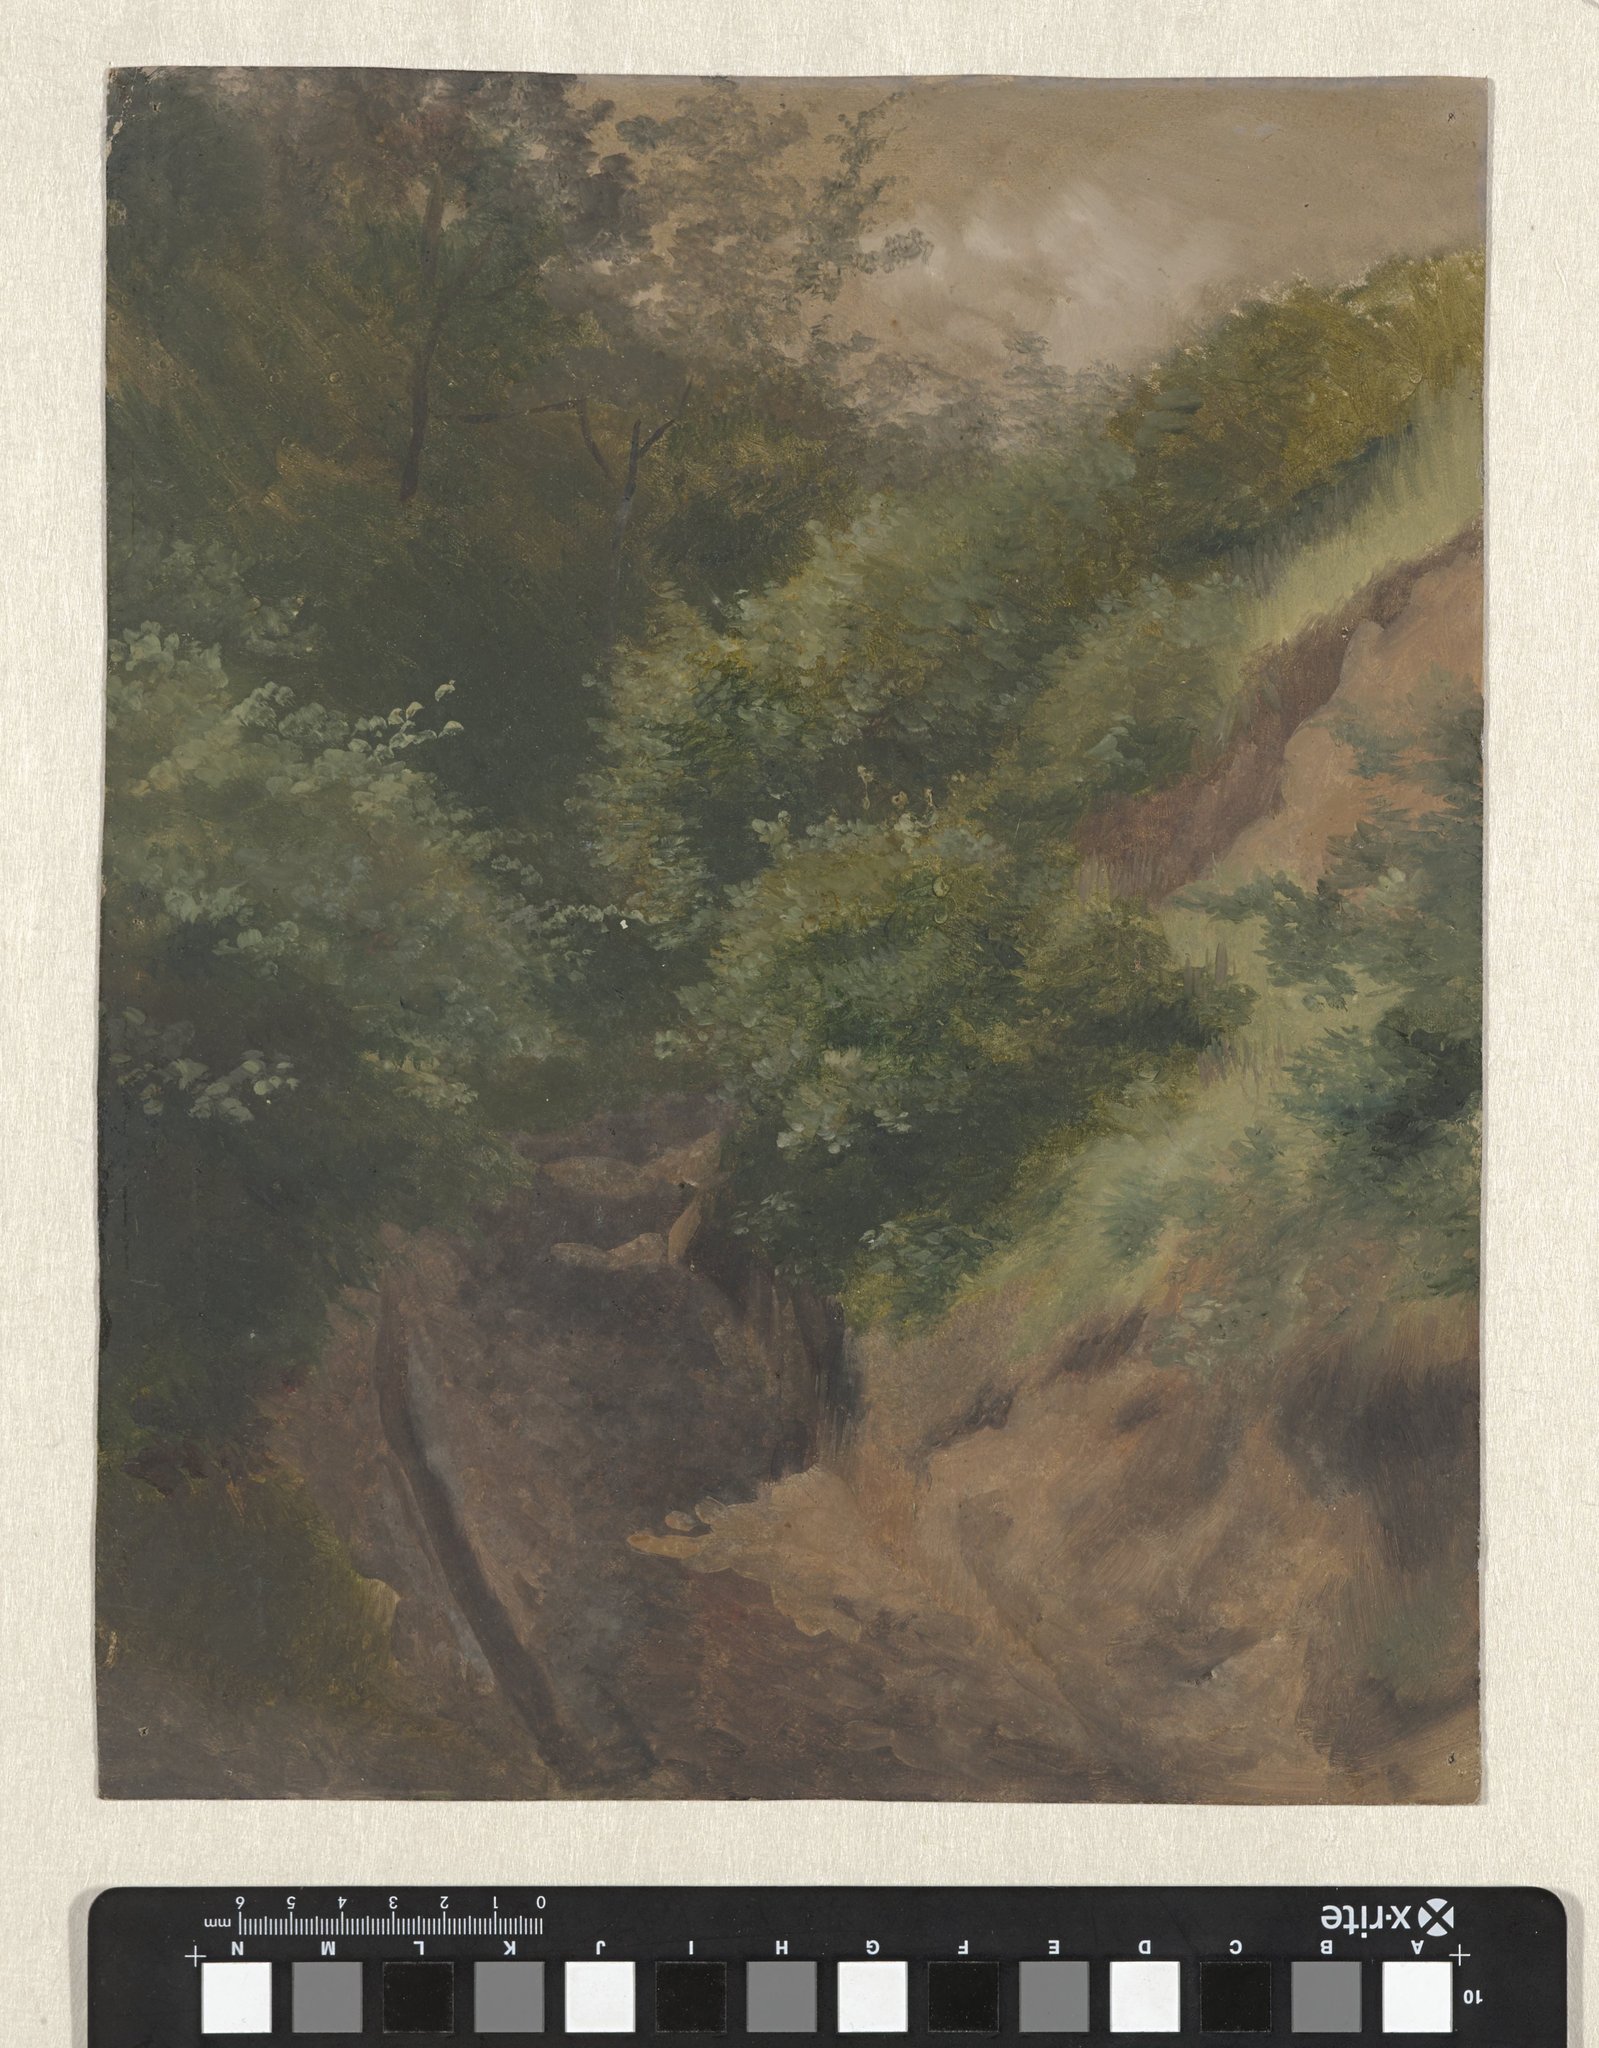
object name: drawing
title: Duinweg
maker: guillaume anne van der brugghen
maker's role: draughtsman, print maker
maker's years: 1812-1891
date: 1821-1891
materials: cardboard, oil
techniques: brush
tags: dunes (sea not visible); in the dunes